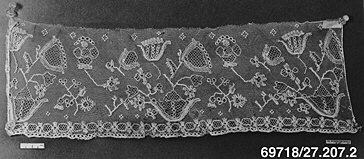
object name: strip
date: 1800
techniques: lace